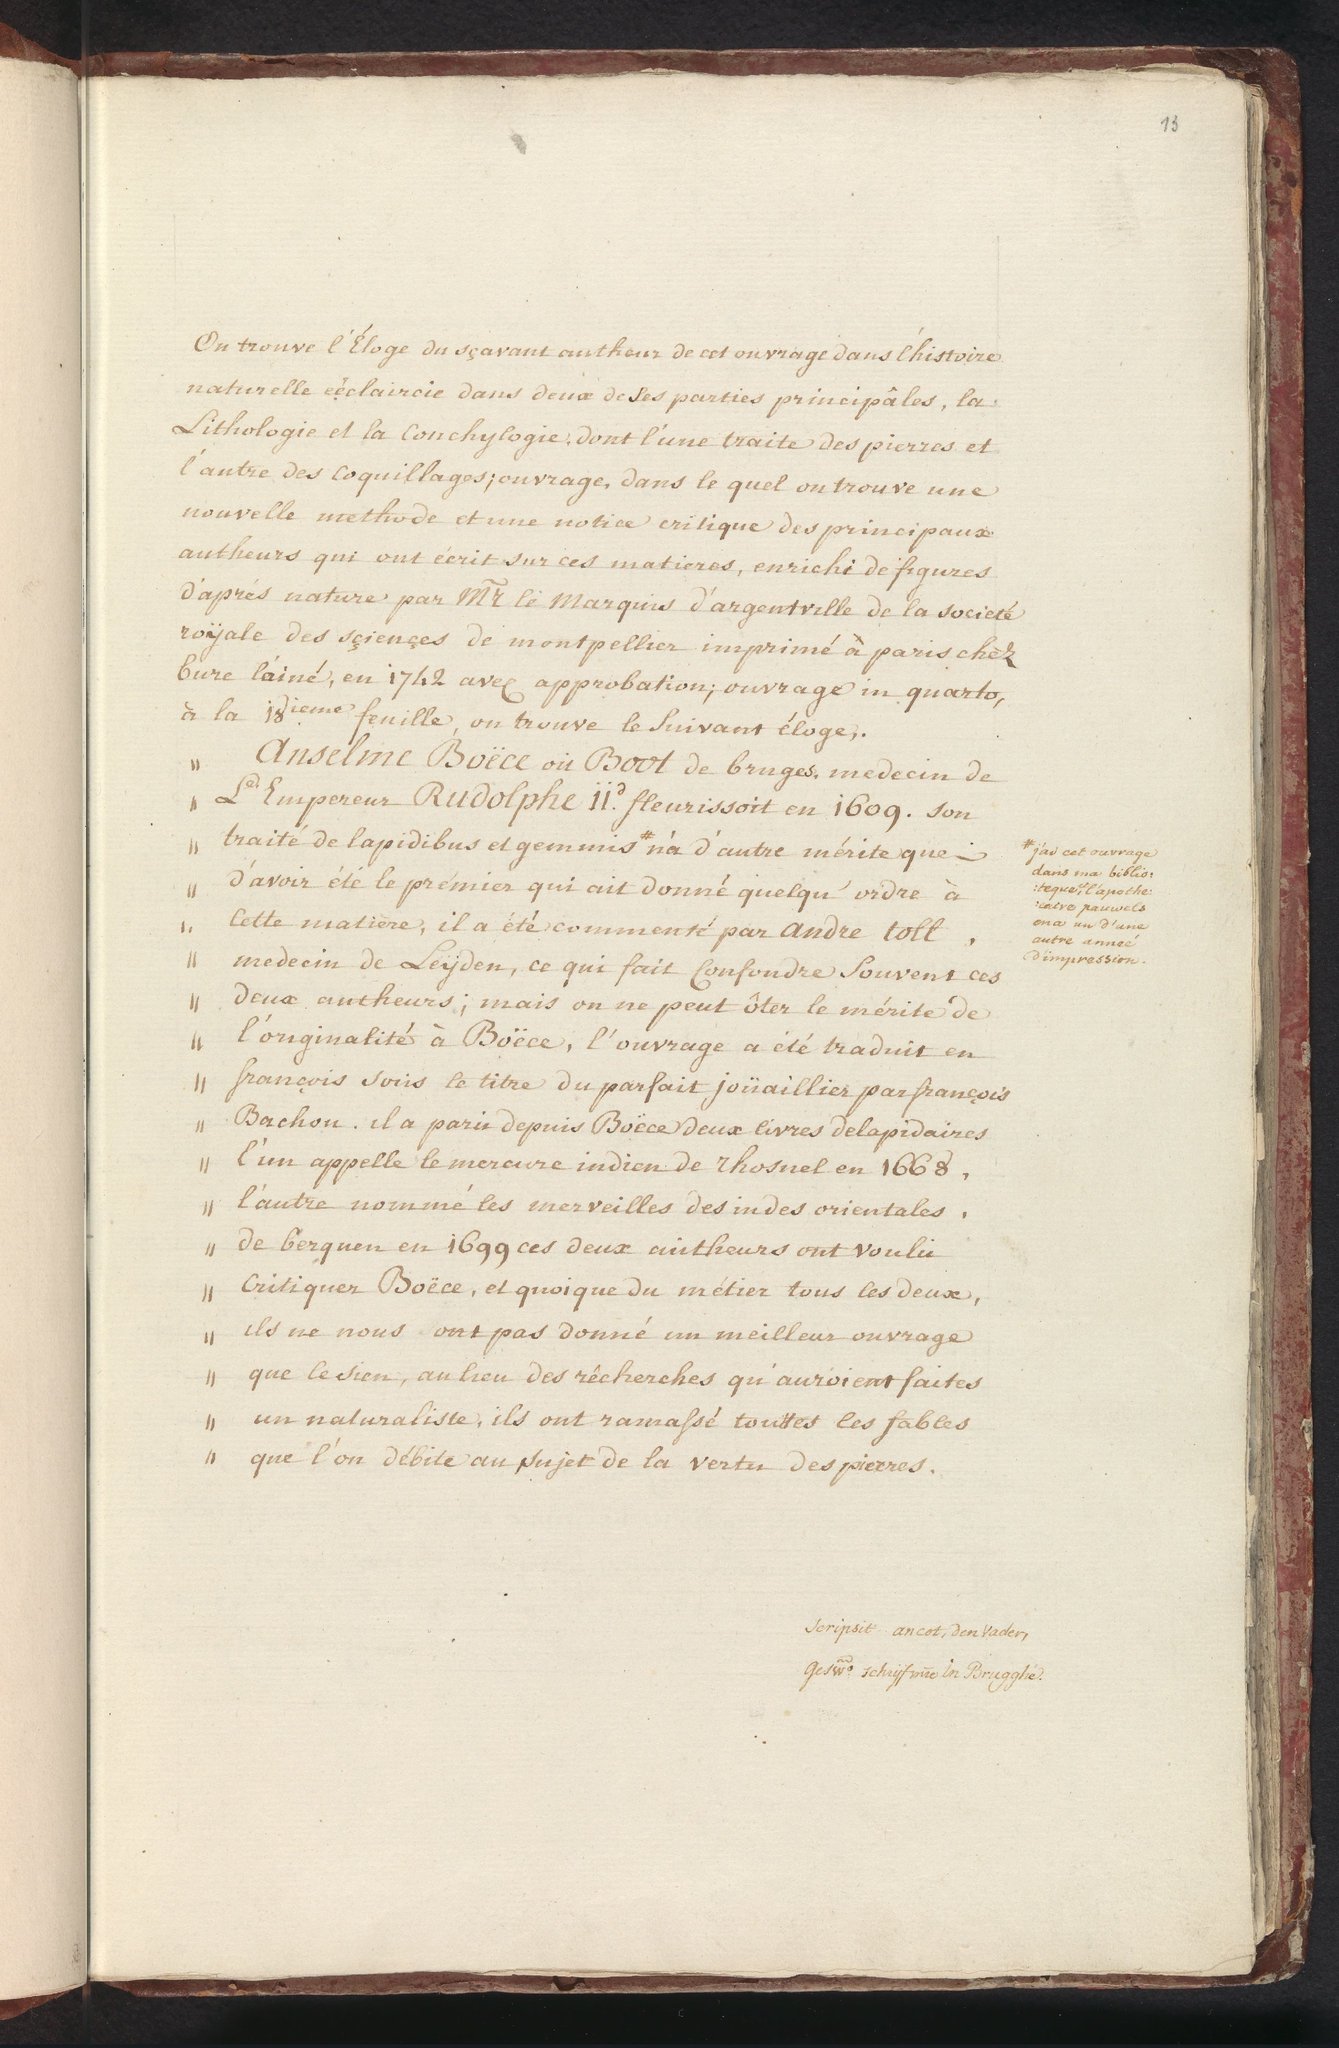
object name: manuscript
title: Tekst over Anselmus de Boodt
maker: ancot (sr.)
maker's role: schrijver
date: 1800-1825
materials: ink, paper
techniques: handwriting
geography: bruges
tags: bruges, draughtsman, anselmus boëtius de boodt, handwriting, written text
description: Franse tekst over Anselmus de Boodt. Onderdeel van het eerste album met tekeningen van viervoeters. Eerste van twaalf albums met tekeningen van dieren, vogels en planten bekend rond 1600, gemaakt in opdracht van keizer Rudolf II. Met toelichting in Nederlands, Latijn en Frans.